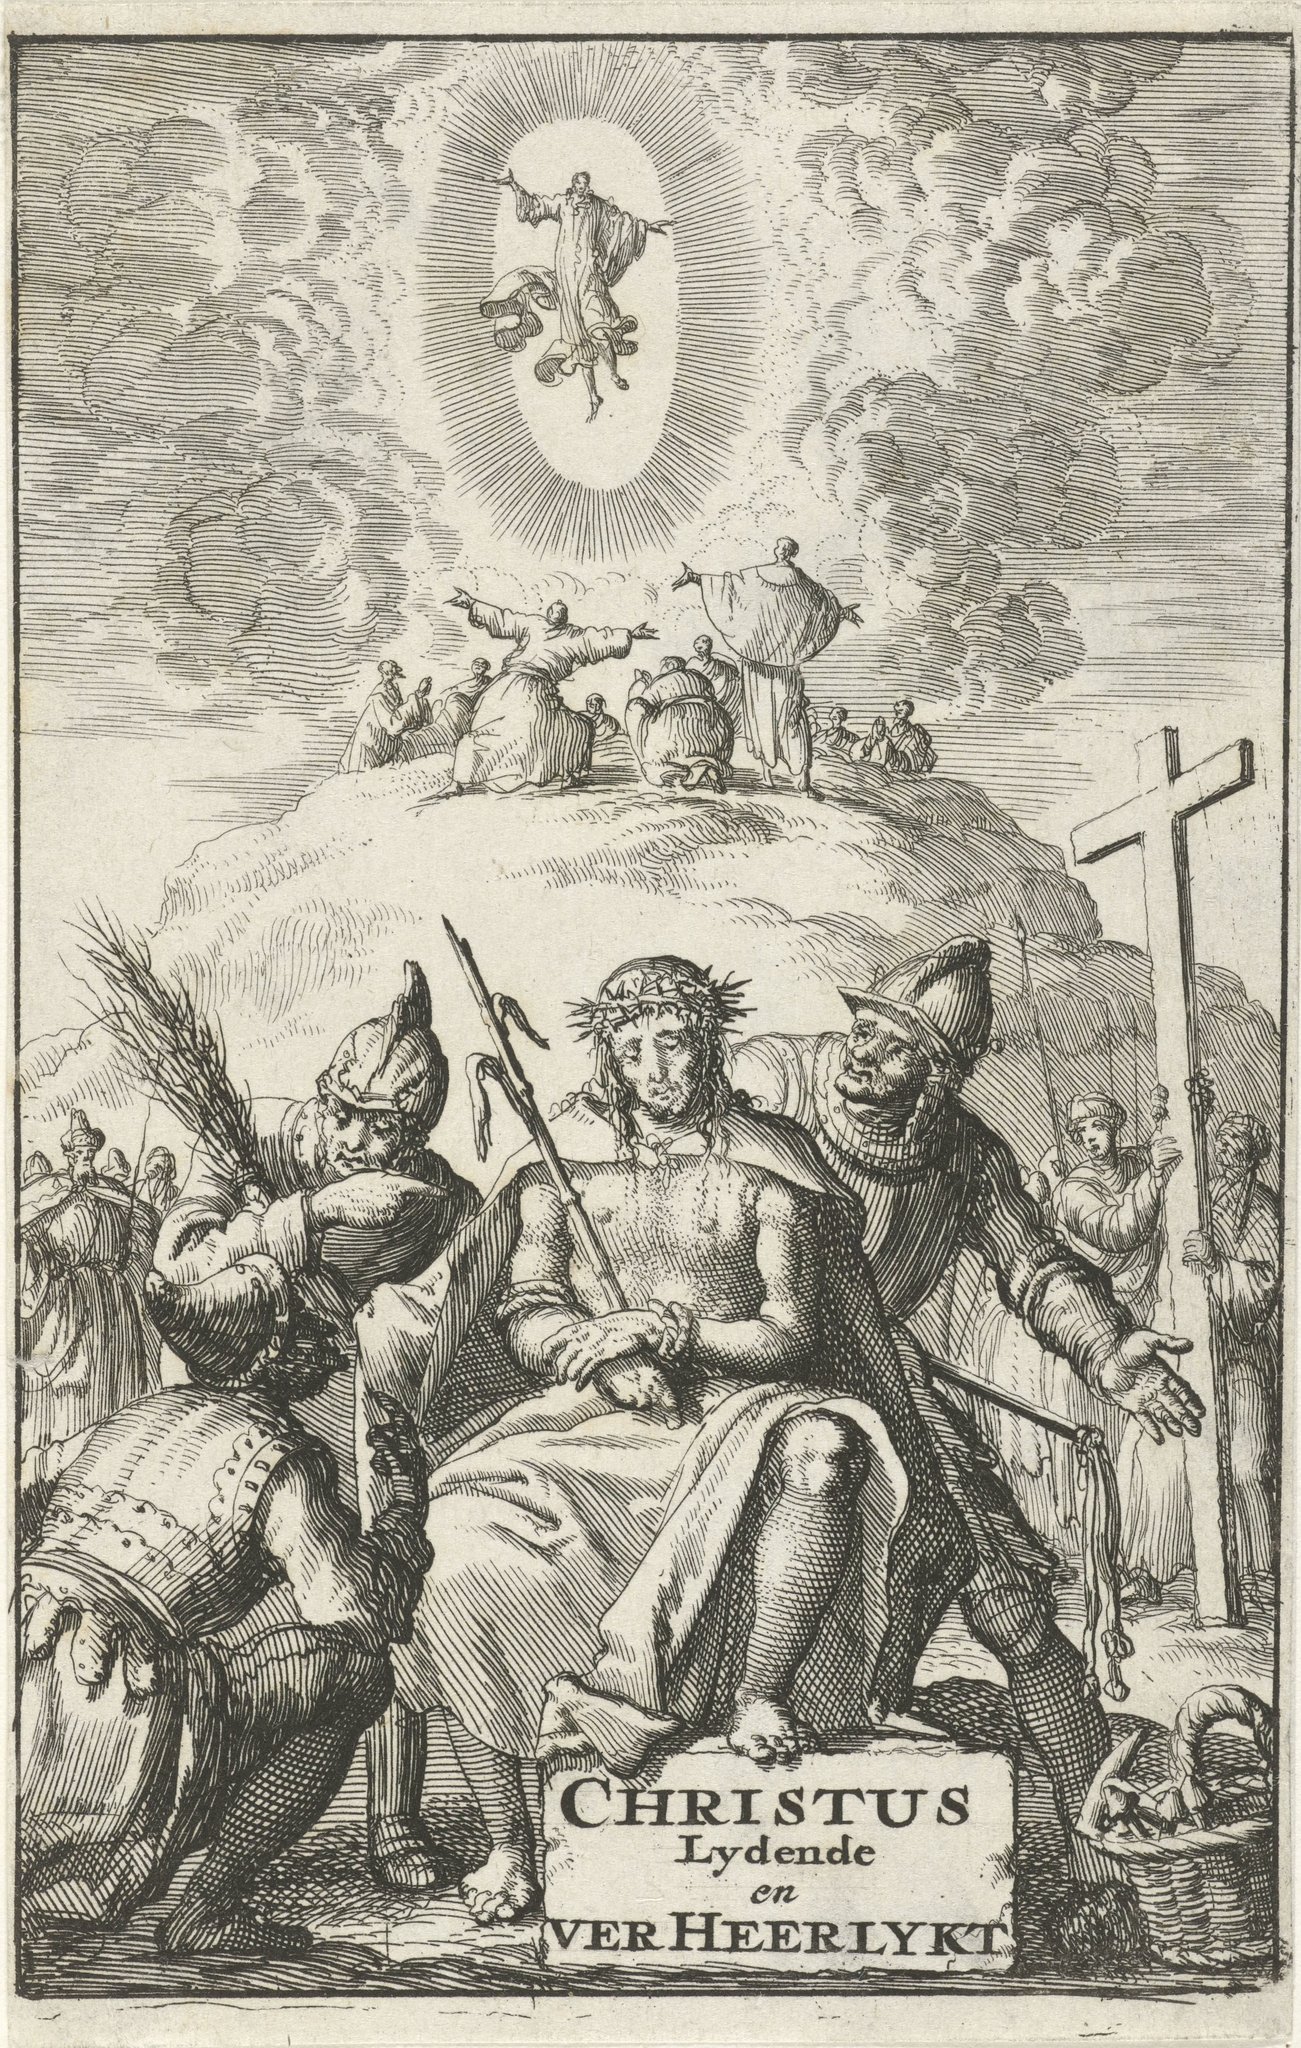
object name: print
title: Titelpagina voor: P. Langedult, Christus lydende, en verheerlykt, 1684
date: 1684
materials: paper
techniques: etching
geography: amsterdam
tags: mockings of christ, who may be blindfolded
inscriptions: collector's mark: Lugt 2228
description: Titelpagina voor: Langedult, Petrus. Christus lydende, en verheerlykt. Het allerheylsaamste treur-spel. Amsterdam: Aart Dircksz Oossaan, 1684.